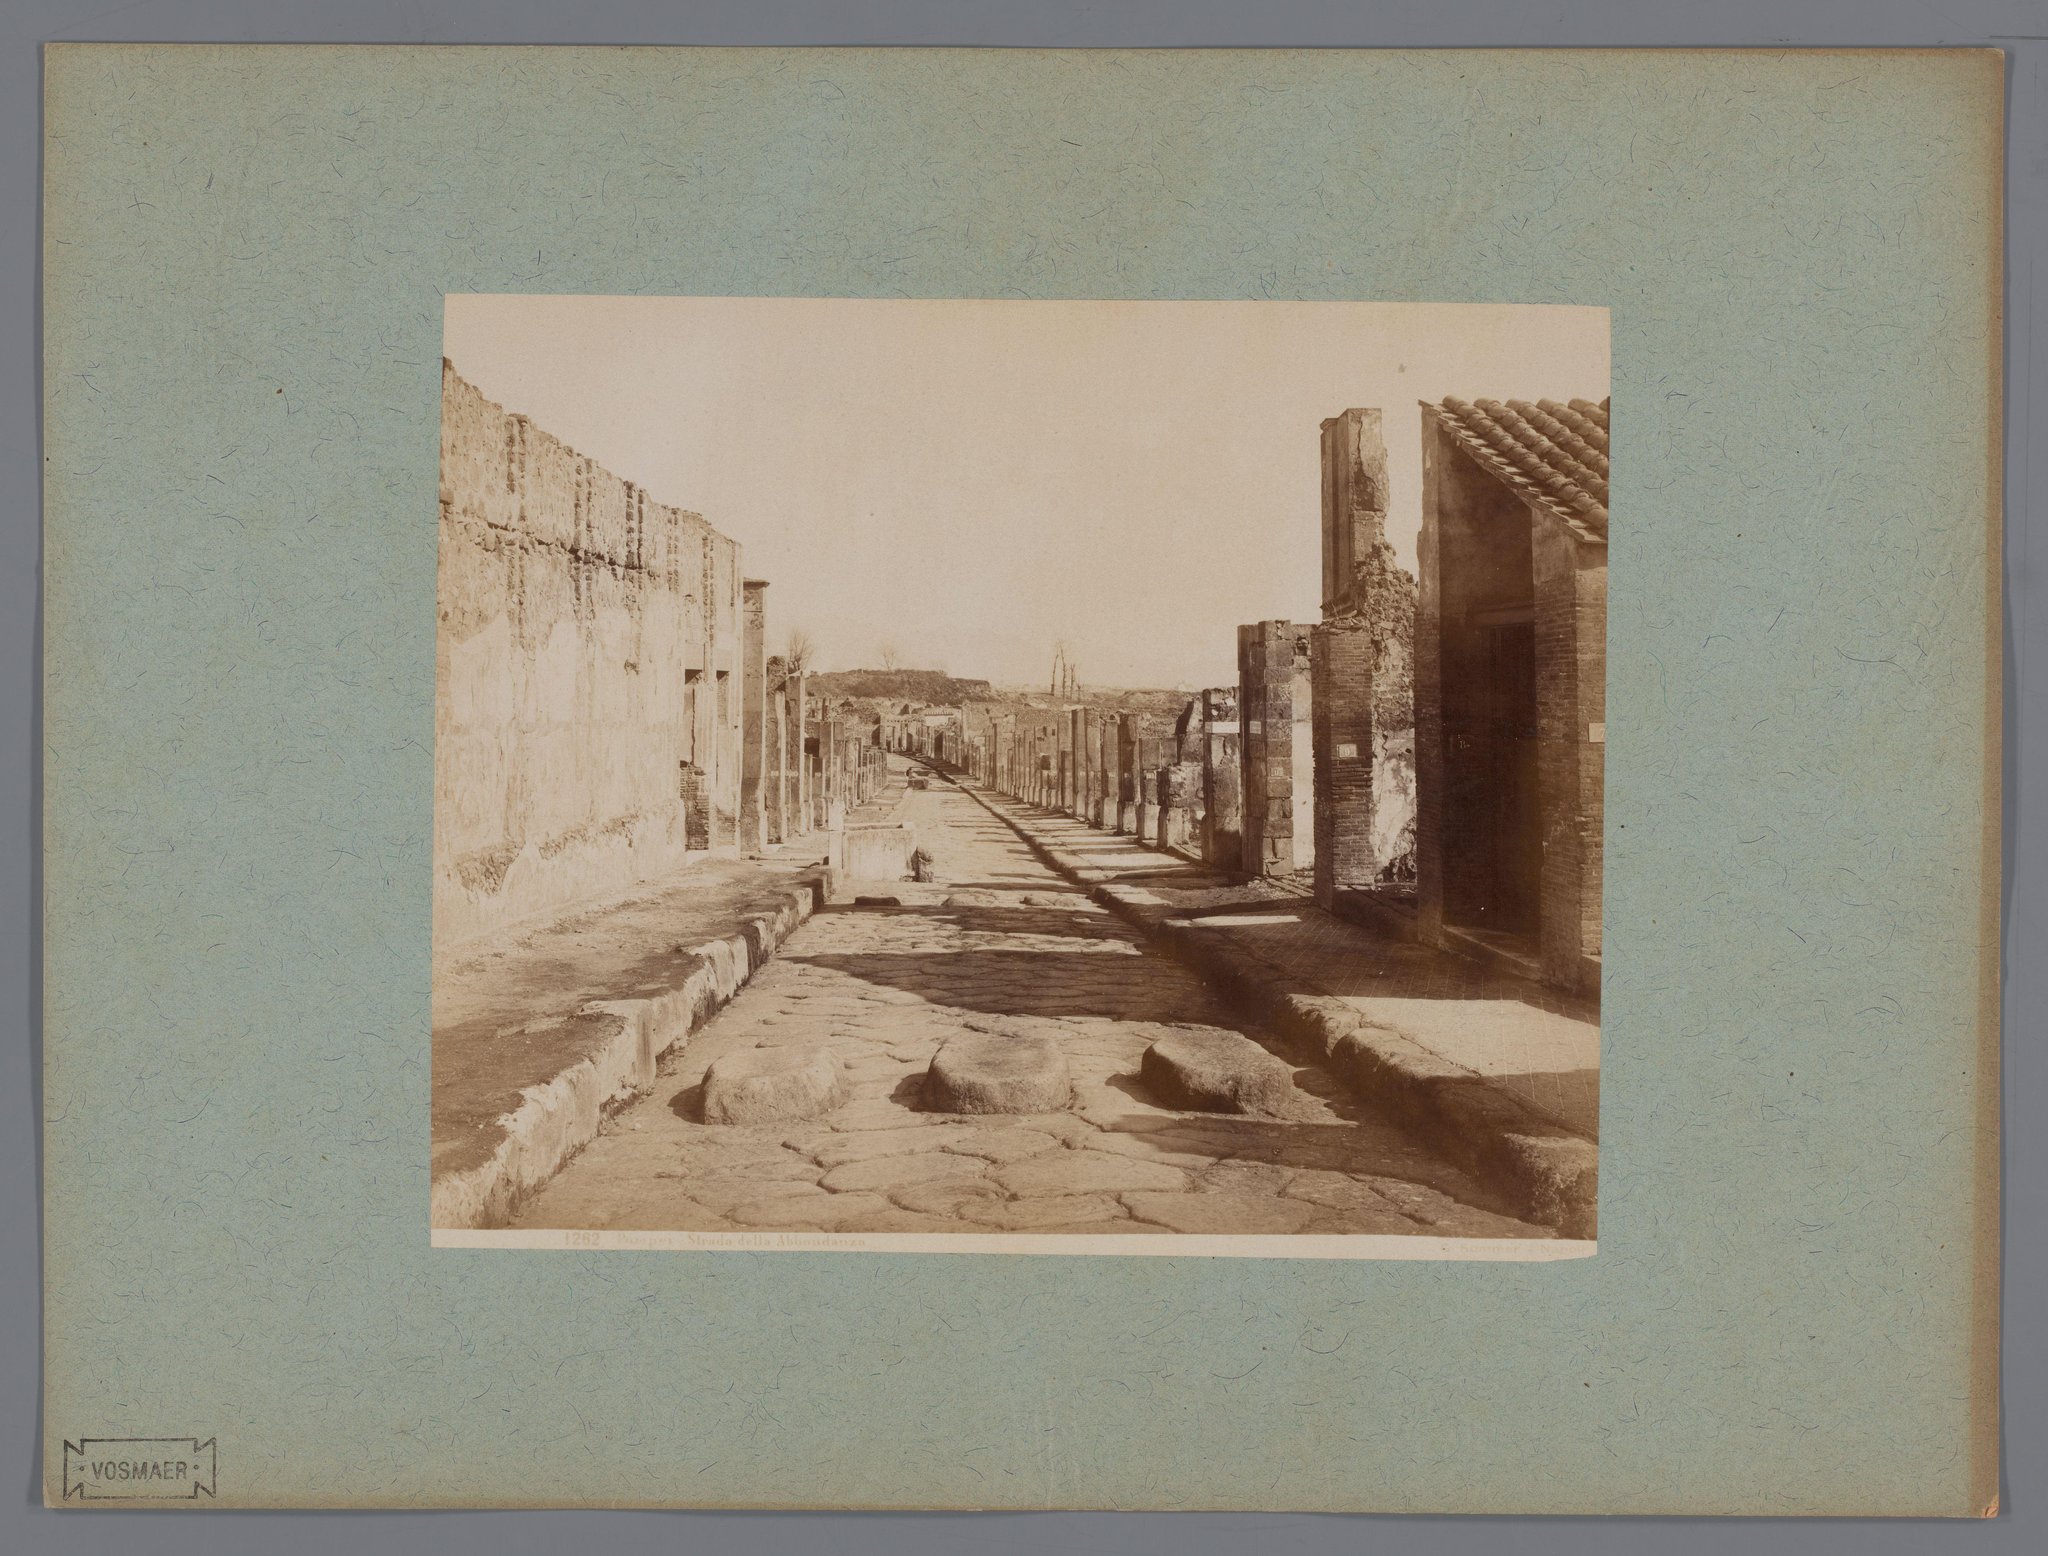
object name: photograph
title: Gezicht op de Strada della Abbondanza te Pompeï, Italië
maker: giorgio sommer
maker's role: fotograaf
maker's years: 1834-1914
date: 1857-1875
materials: cardboard, paper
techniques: albumen print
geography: pompeii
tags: ruin of a building ~ architecture, landscape with ruins, street, pompeii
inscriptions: number: ‘1262’, collector's mark: ‘VOSMAER’